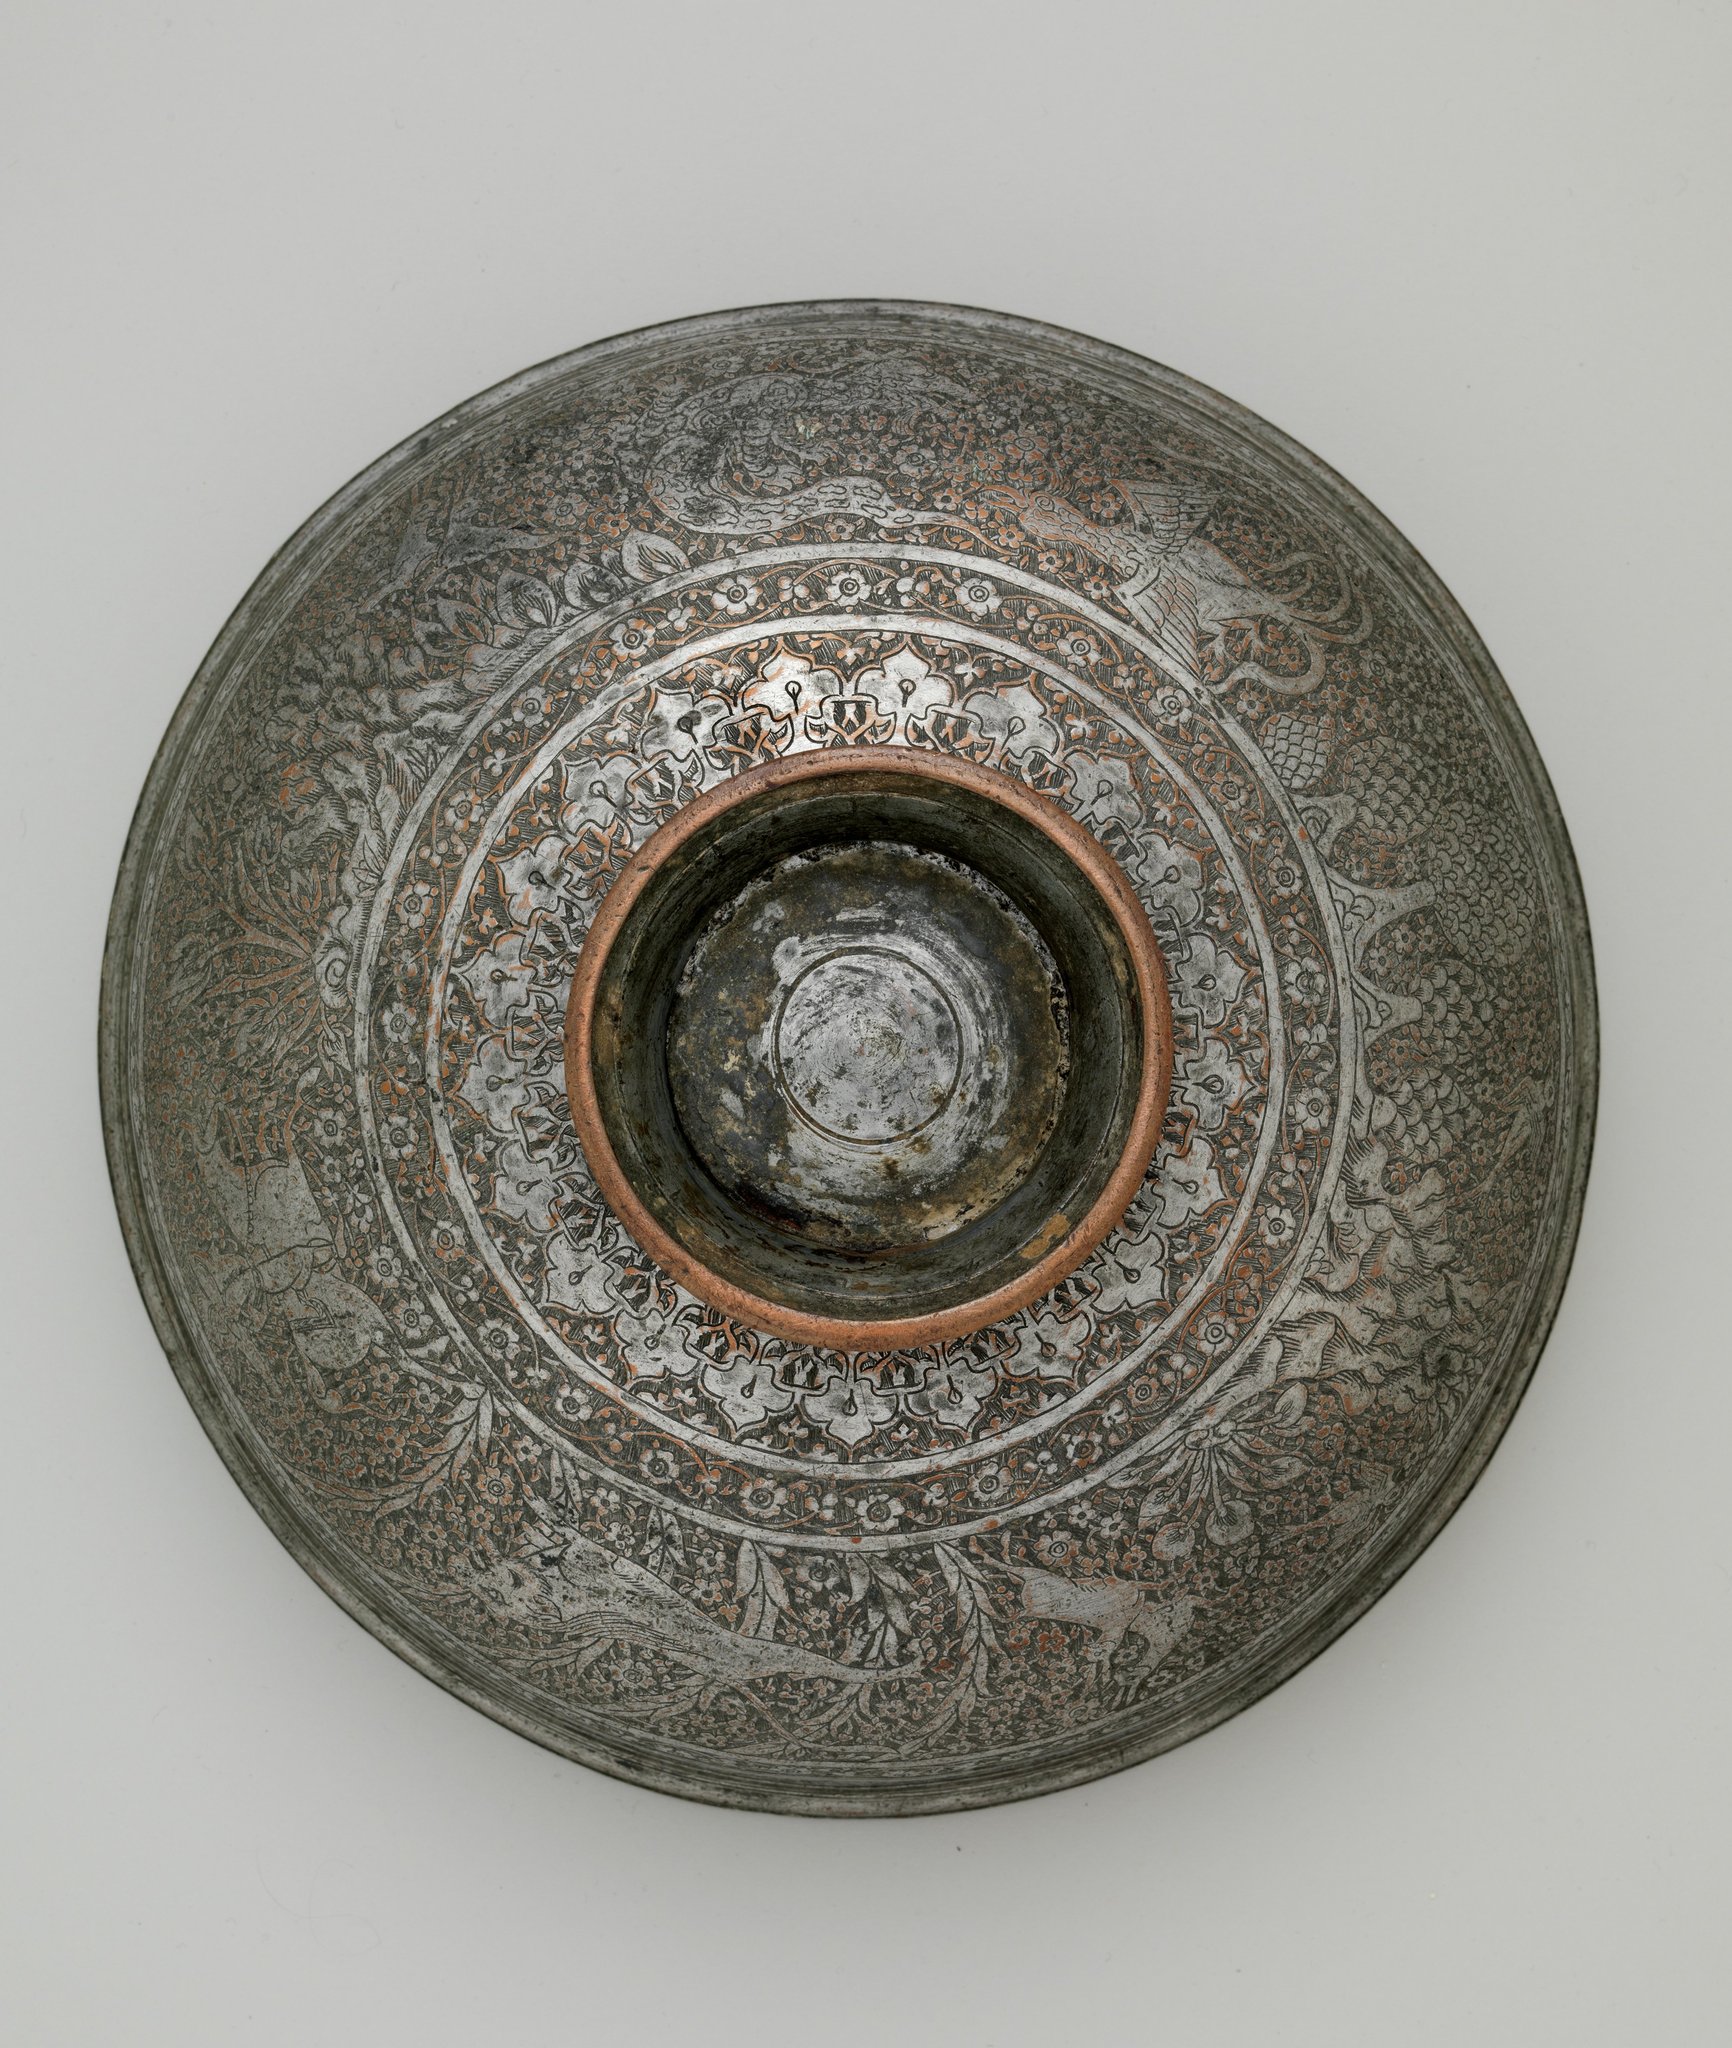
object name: bowl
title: Engraved Bowl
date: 1601-1633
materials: copper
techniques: casting, engraving, inlay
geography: india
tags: birds,men,hunting,horses